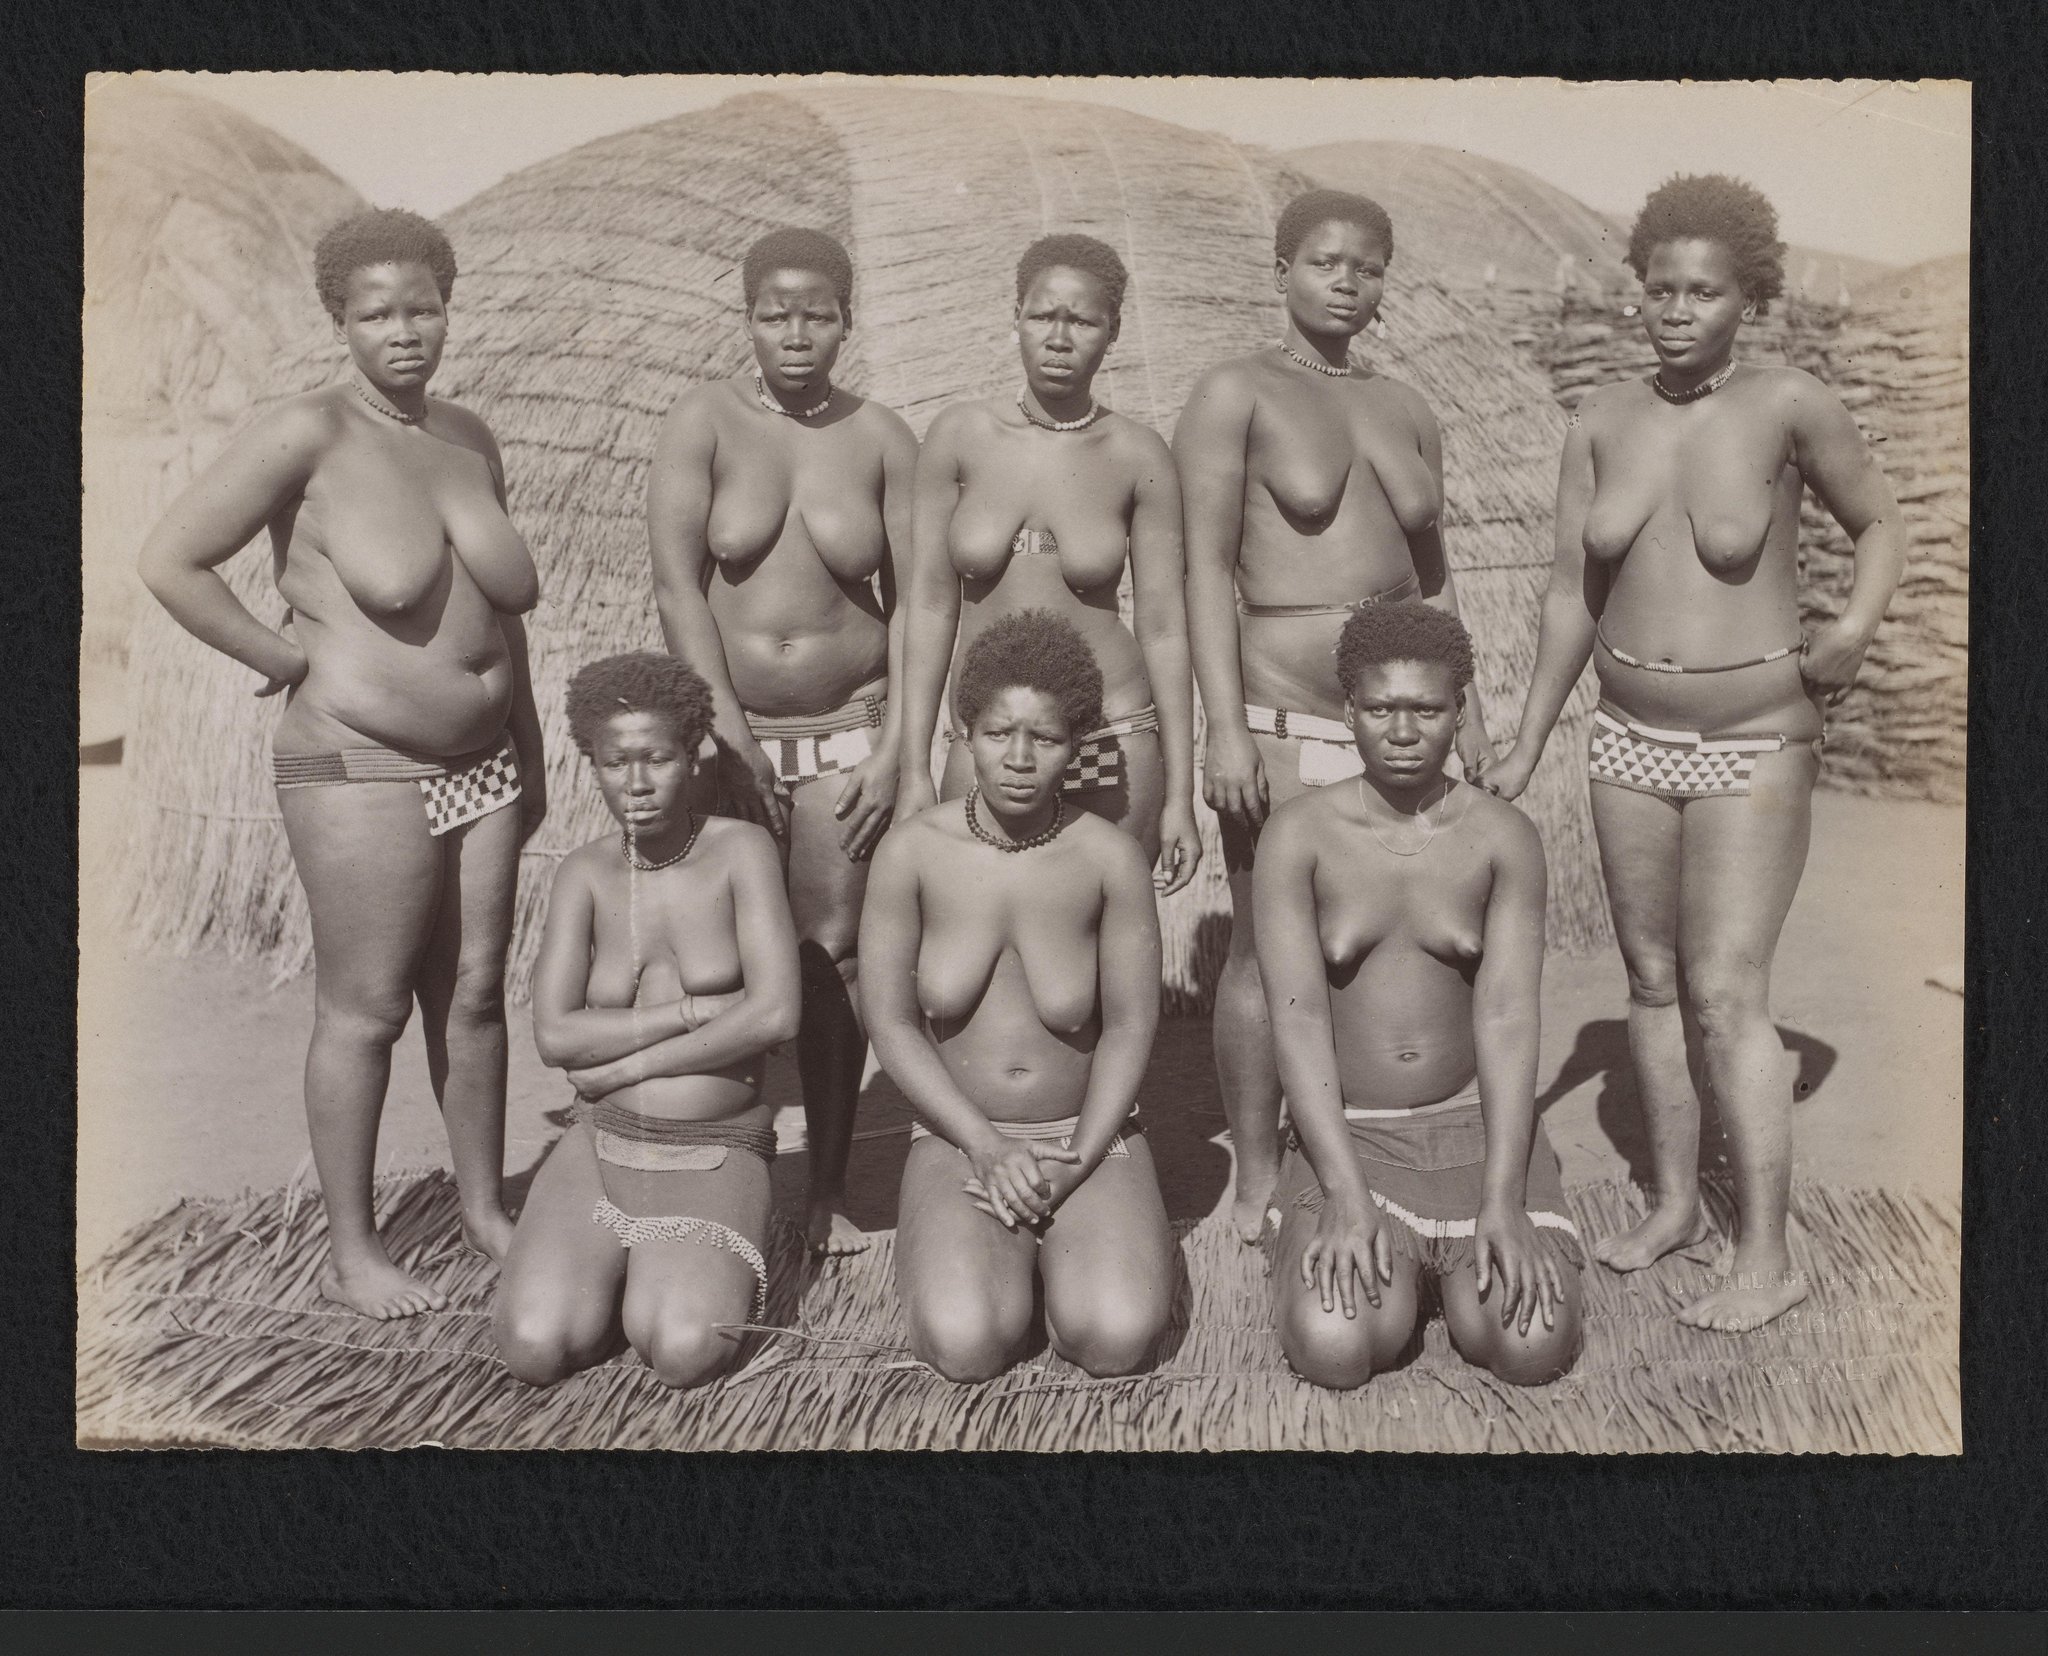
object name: photograph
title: Groepsportret met acht Zoeloe vrouwen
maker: j. wallace bradley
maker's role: fotograaf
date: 1896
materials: photographic support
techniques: gelatin silver print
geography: natal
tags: anonymous historical persons portrayed in a group, in a group-portrait - bb - woman, historical persons - bb - woman, the (nude) human figure; 'corpo humano' (ripa) - aa - female human figure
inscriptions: inscription: ‘J. Wallace Bradley/ Durban/ Natal’